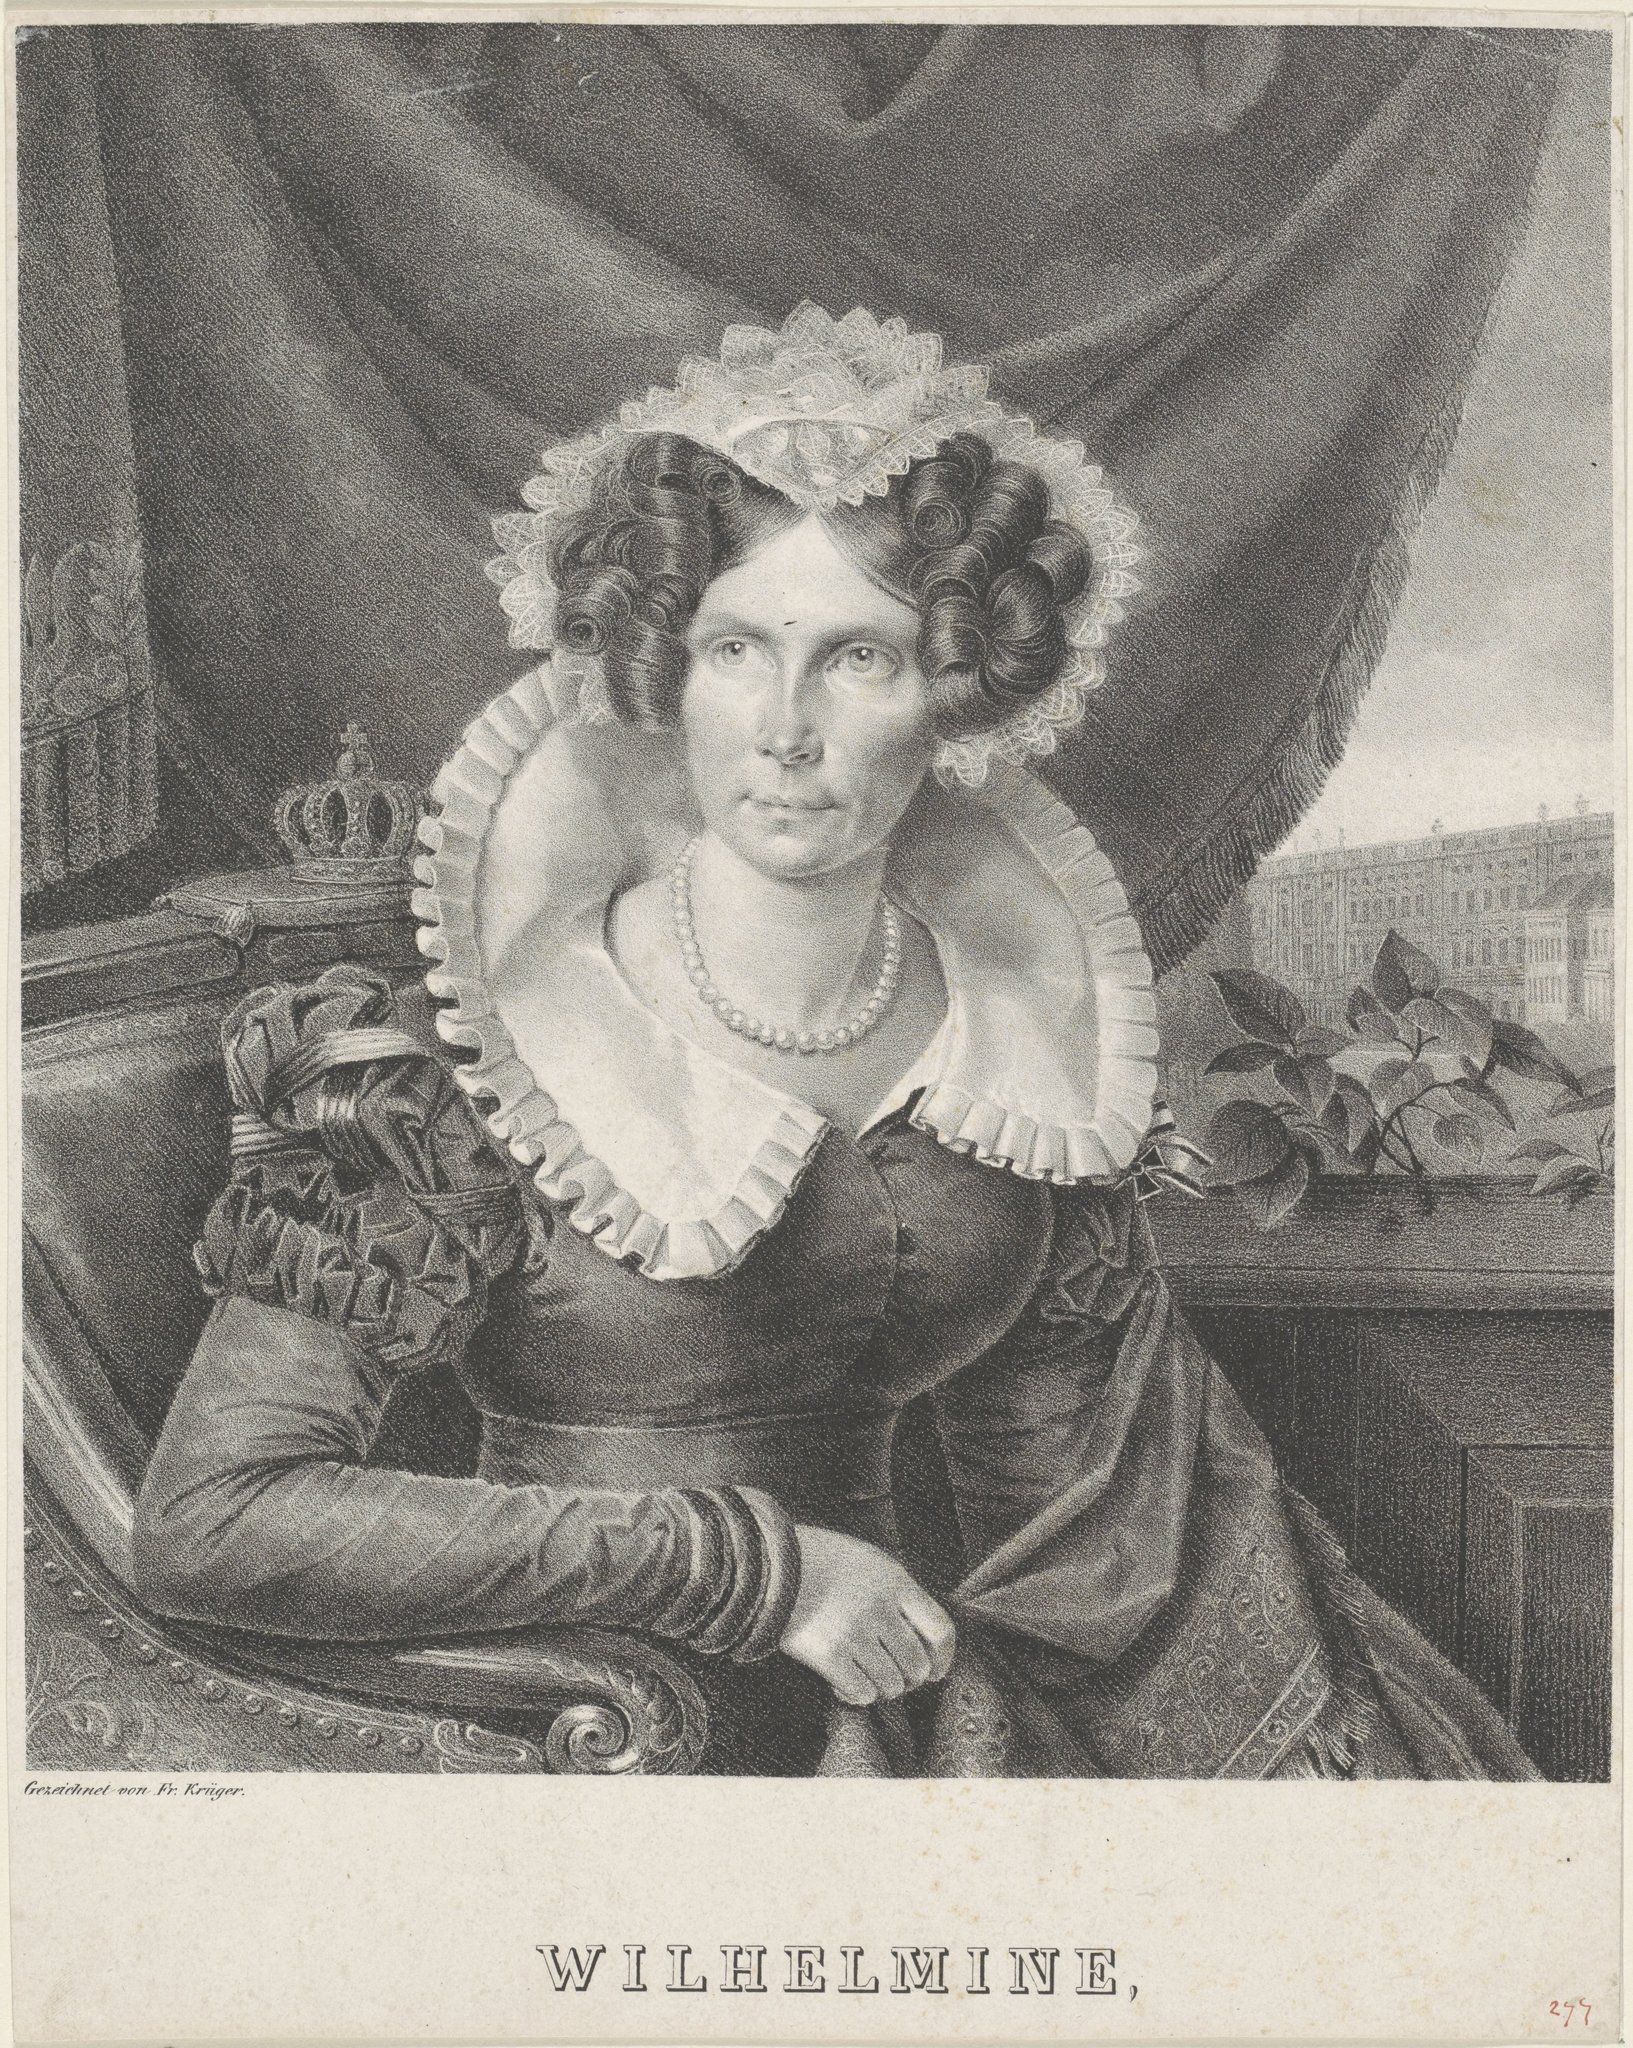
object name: print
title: Portret van Wilhelmina van Pruisen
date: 1815-1899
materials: paper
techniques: lithograph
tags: berlin, the hague, wilhelmina frederica louisa (koningin der nederlanden)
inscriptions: collector's mark: Lugt 2228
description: Portret van Wilhelmina. Ze zit in een armstoel. Rechts een doorkijkje naar een paleis. In de ondermarge haar naam.